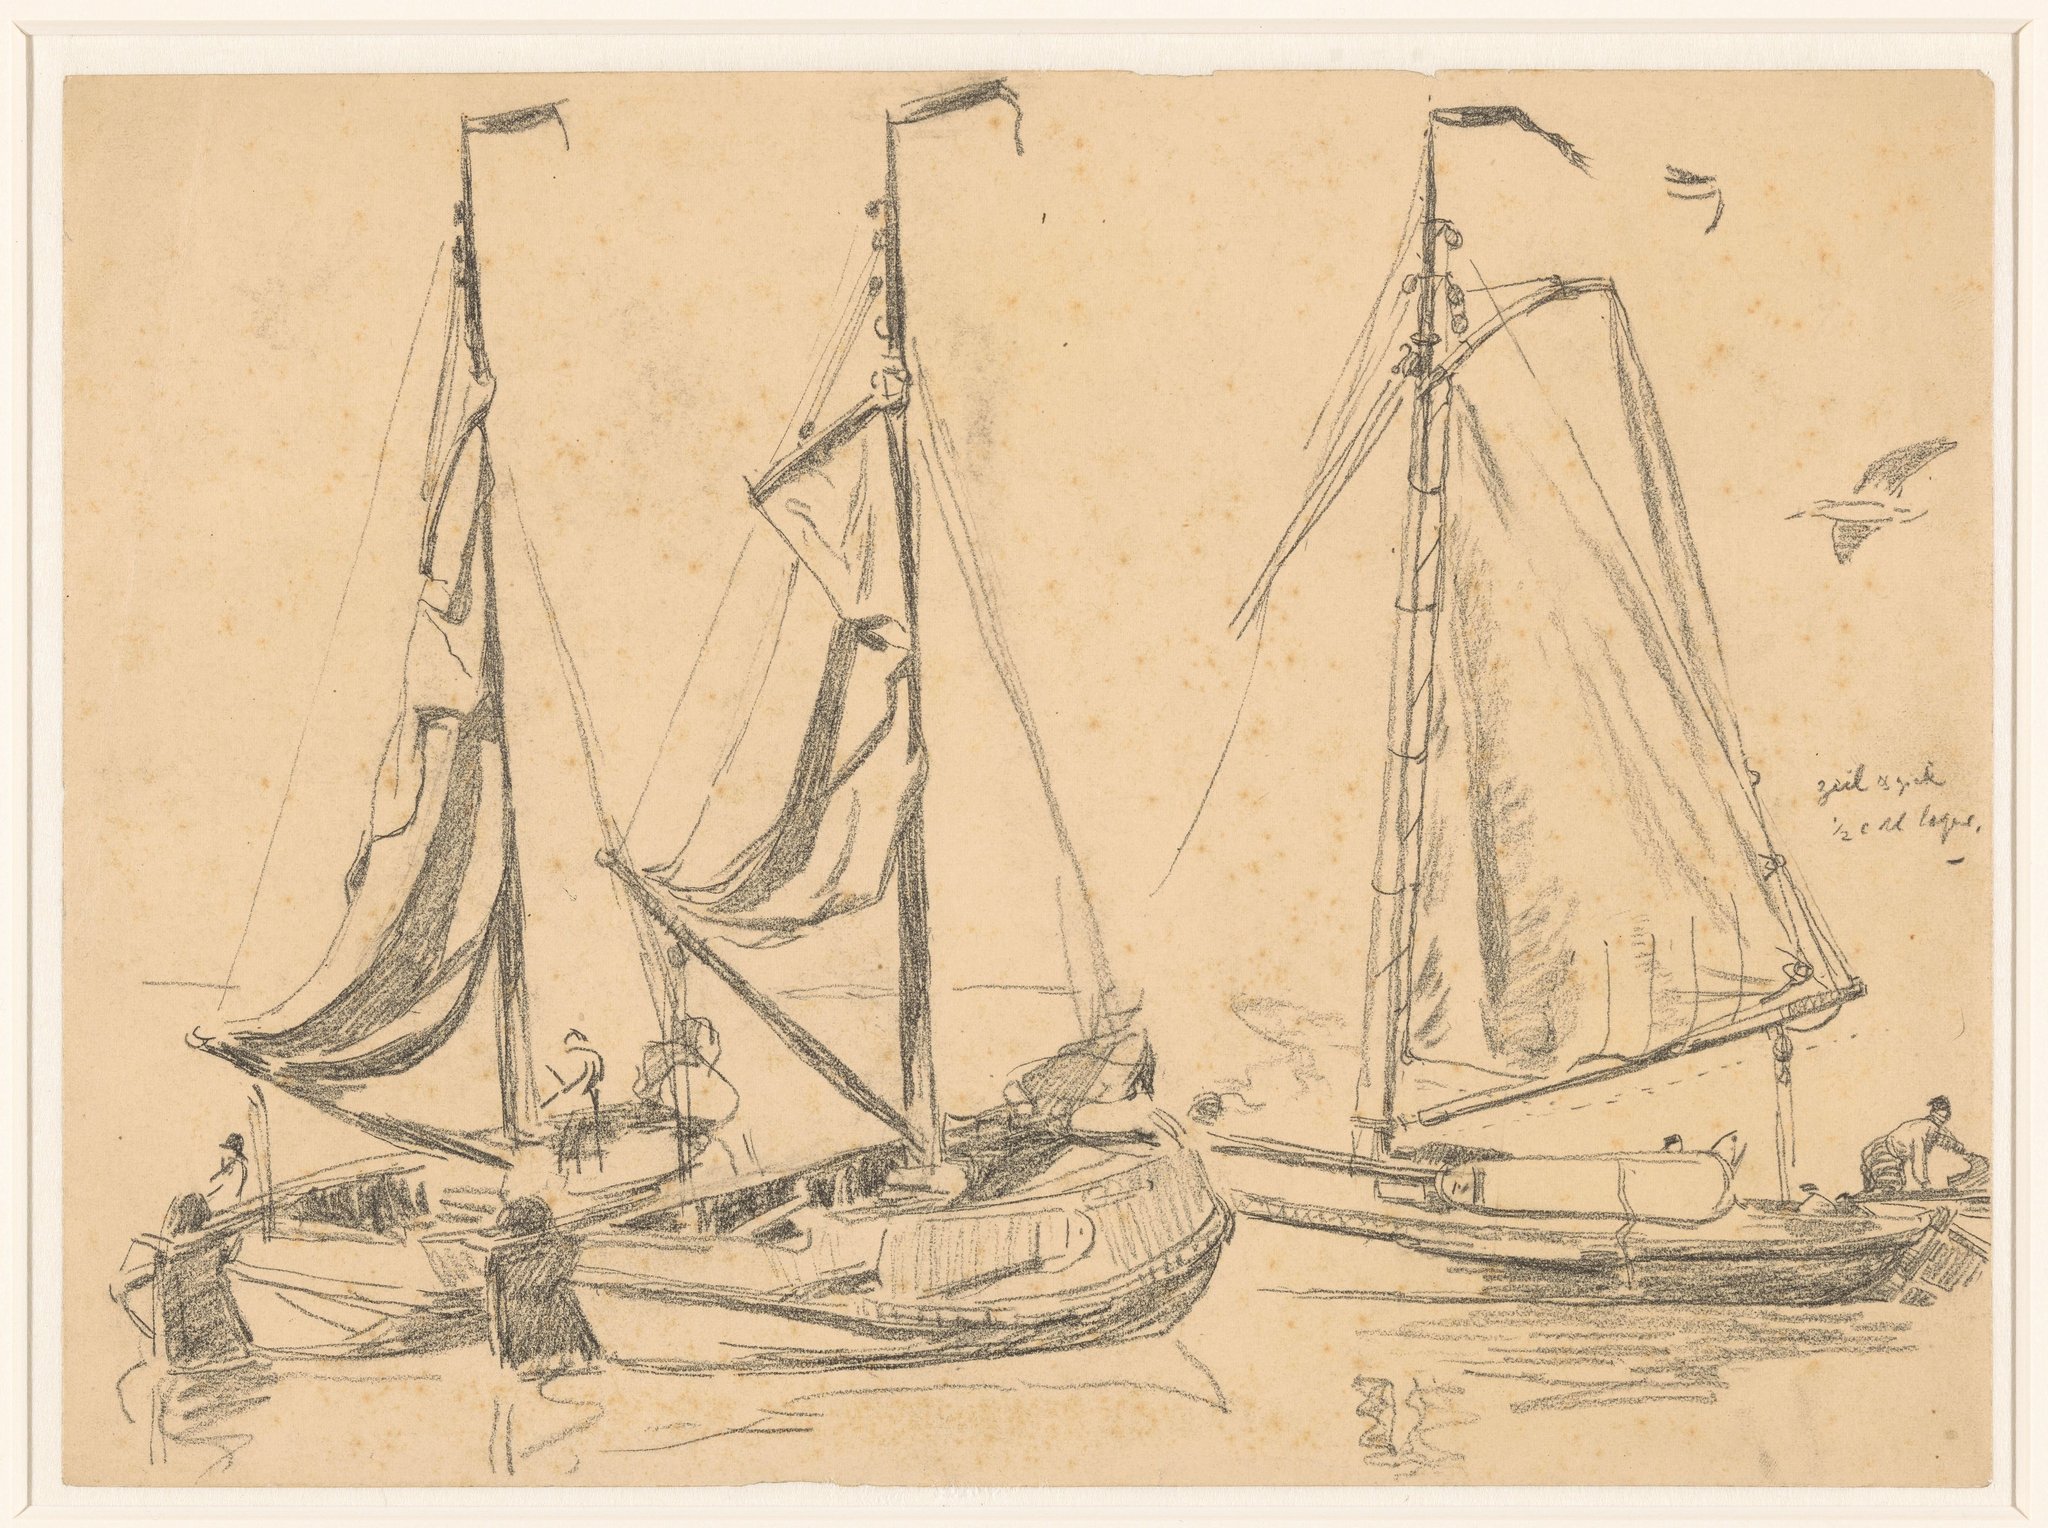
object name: drawing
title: Studieblad met drie boten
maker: willem bastiaan tholen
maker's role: draughtsman, painter, print maker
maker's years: 1860-1931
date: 1870-1931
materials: chalk, paper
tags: ships (in general) - cc - more than one ship